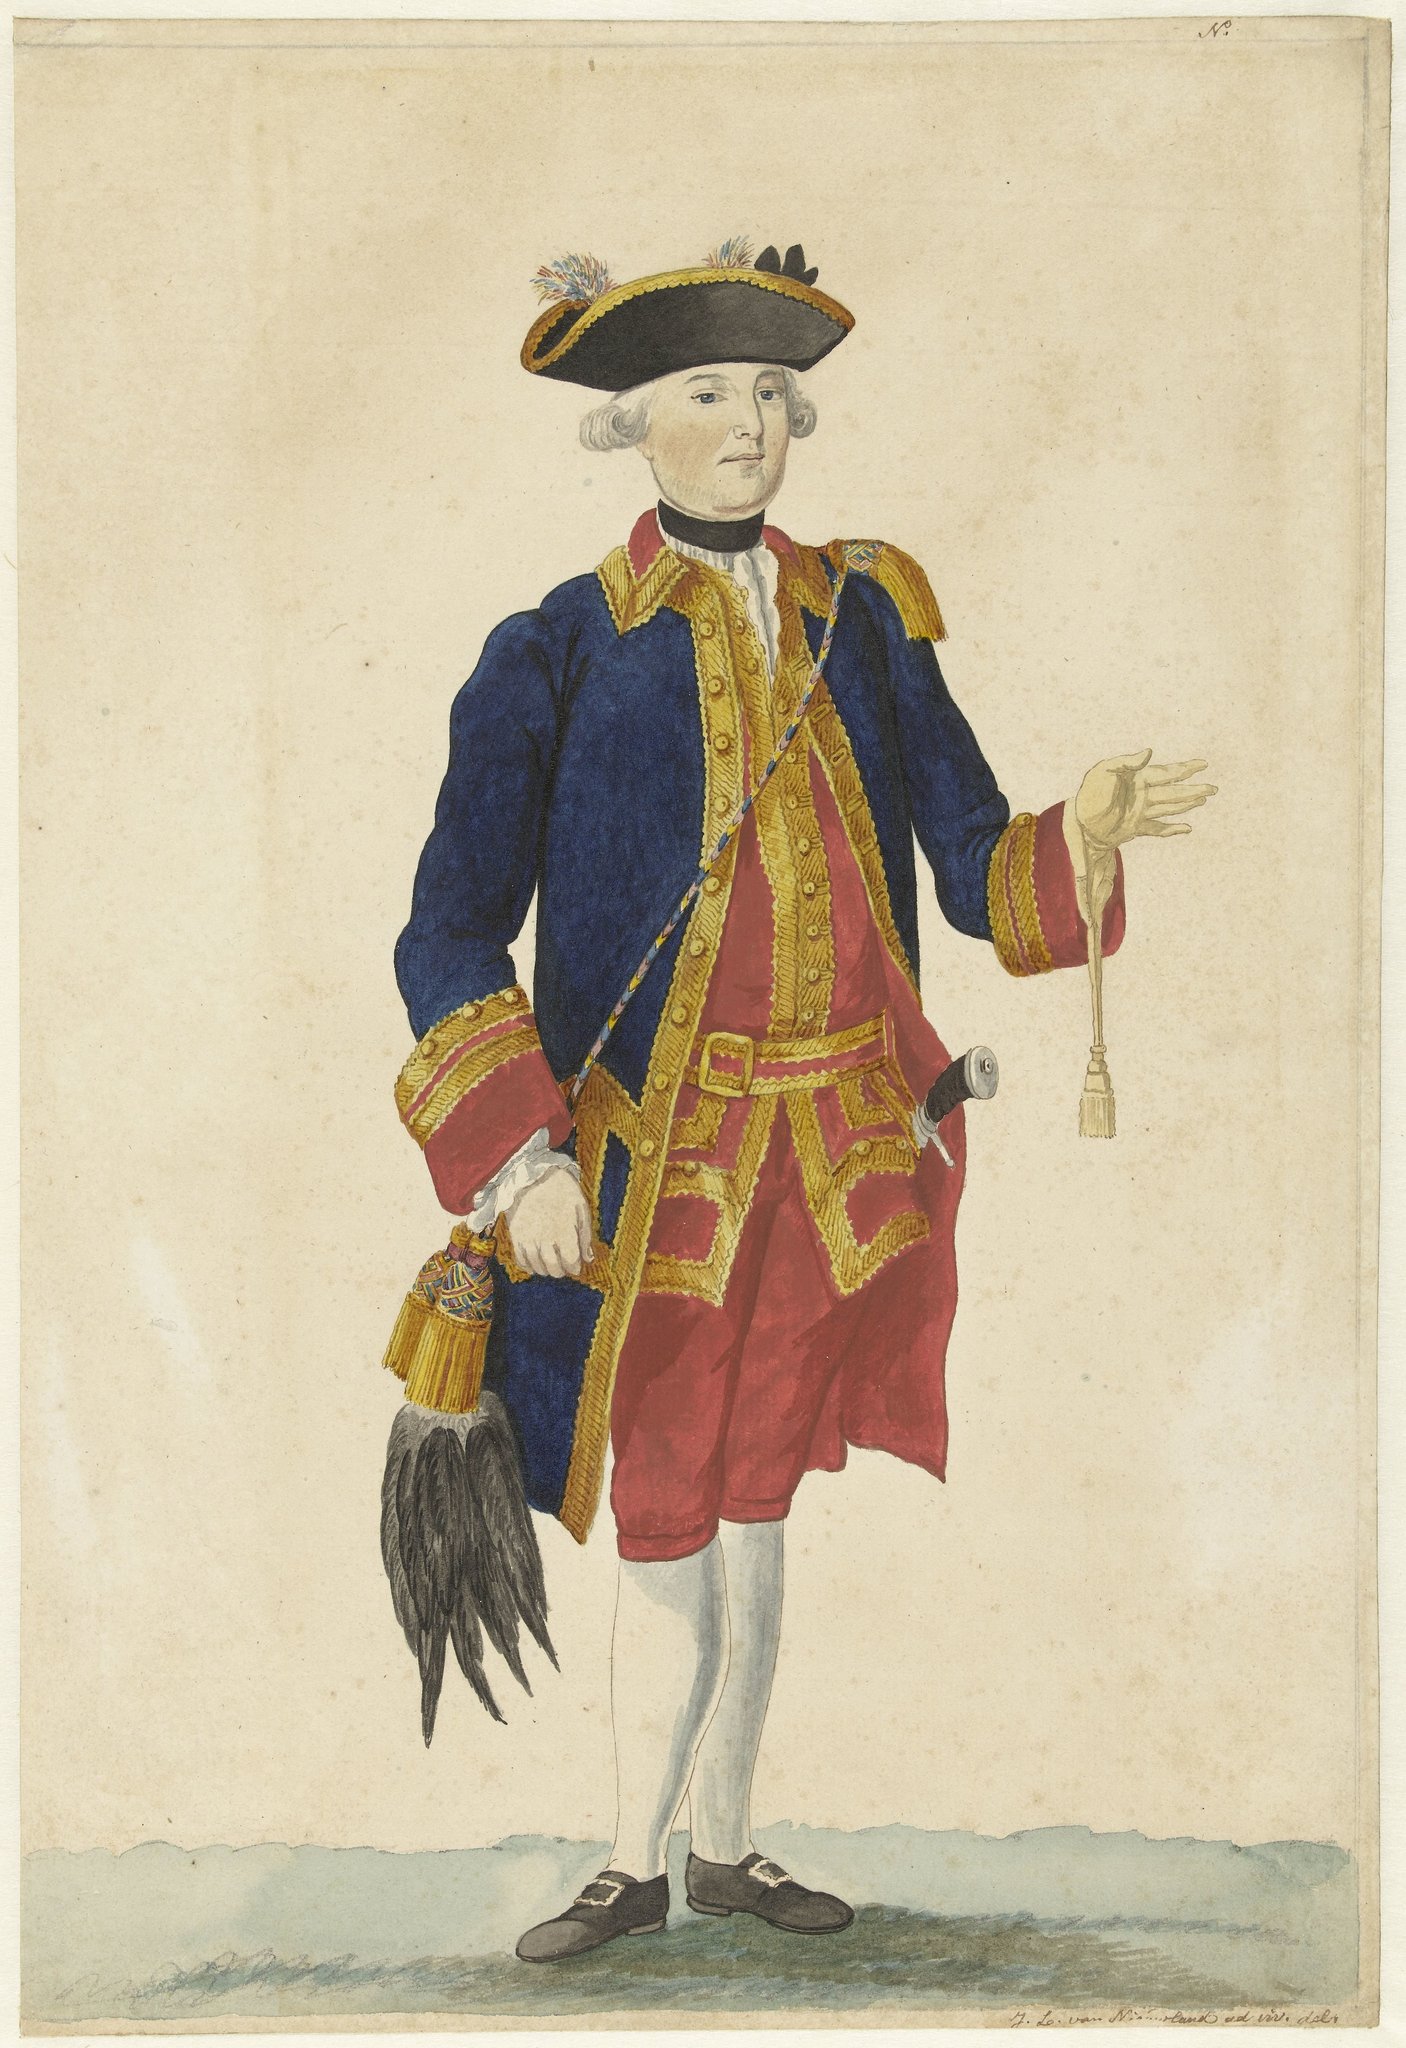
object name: kostuumstudie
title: Costumes van het hof van Willem V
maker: isaac lodewijk la fargue van nieuwland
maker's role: draughtsman, painter, print maker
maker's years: 1726-1805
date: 1766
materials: ink, paper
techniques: brush, pen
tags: william v (prince of orange)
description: Blad 14 uit serie van 24 tekeningen met leden van de hofhouding van stadhouder Willem V.